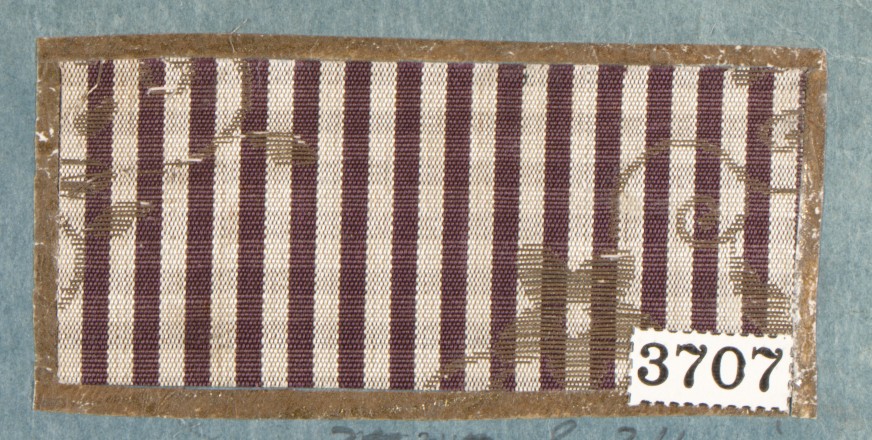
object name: sample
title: Textile Sample from Sample Book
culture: japanese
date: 1801-1900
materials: silk